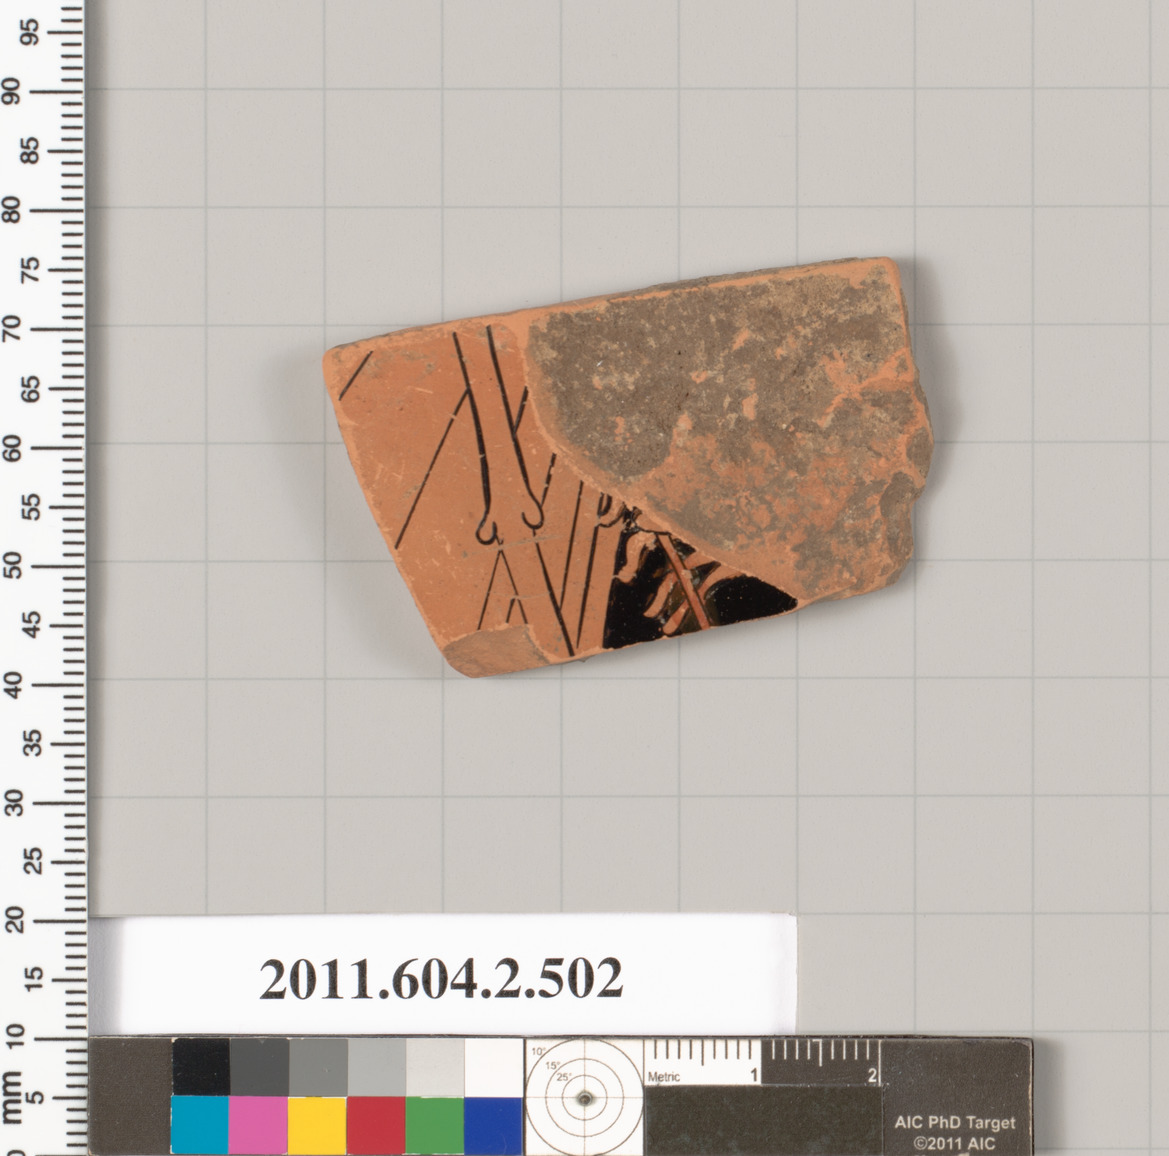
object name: column krater fragment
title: Terracotta fragment of a column-krater (bowl for mixing wine and water)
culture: greek, attic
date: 490-480 BCE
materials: terracotta